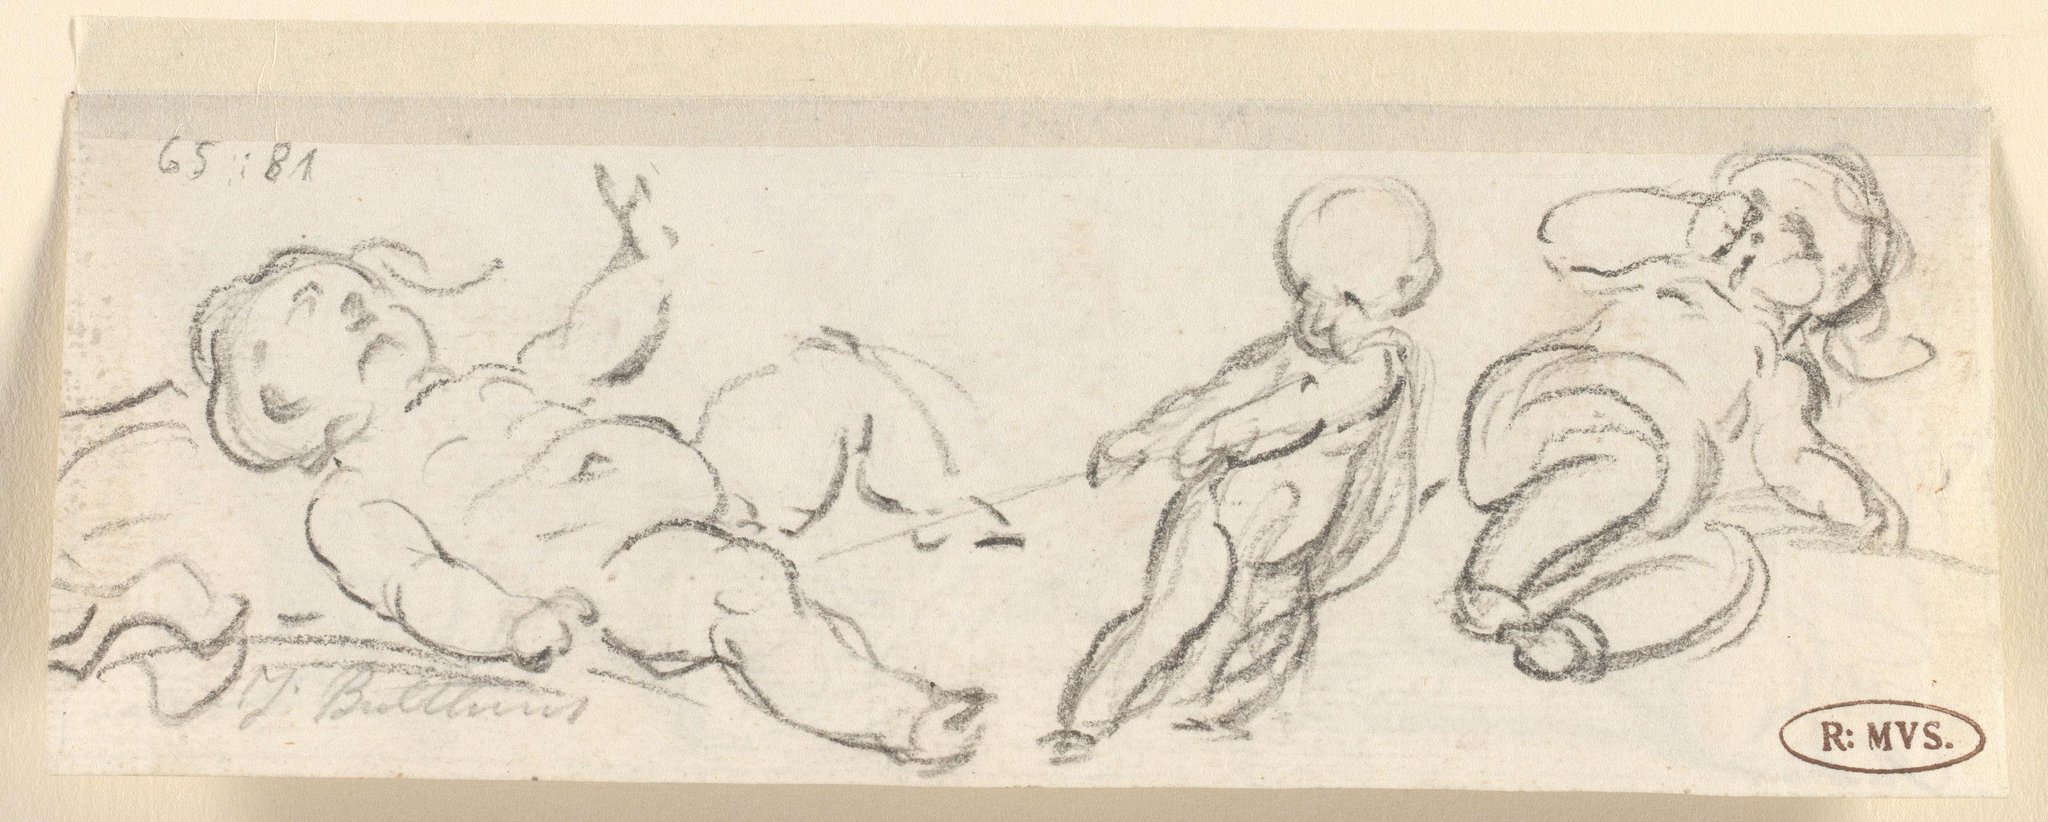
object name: ornamenttekening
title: Putti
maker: jan bulthuis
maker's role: draughtsman, print maker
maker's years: 1750-1801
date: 1760-1801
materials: chalk, paper, pencil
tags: cupids: 'amores', 'amoretti', 'putti'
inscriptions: collector's mark: Lugt 2228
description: Schetsen van een liggende, staande en zittende putto.